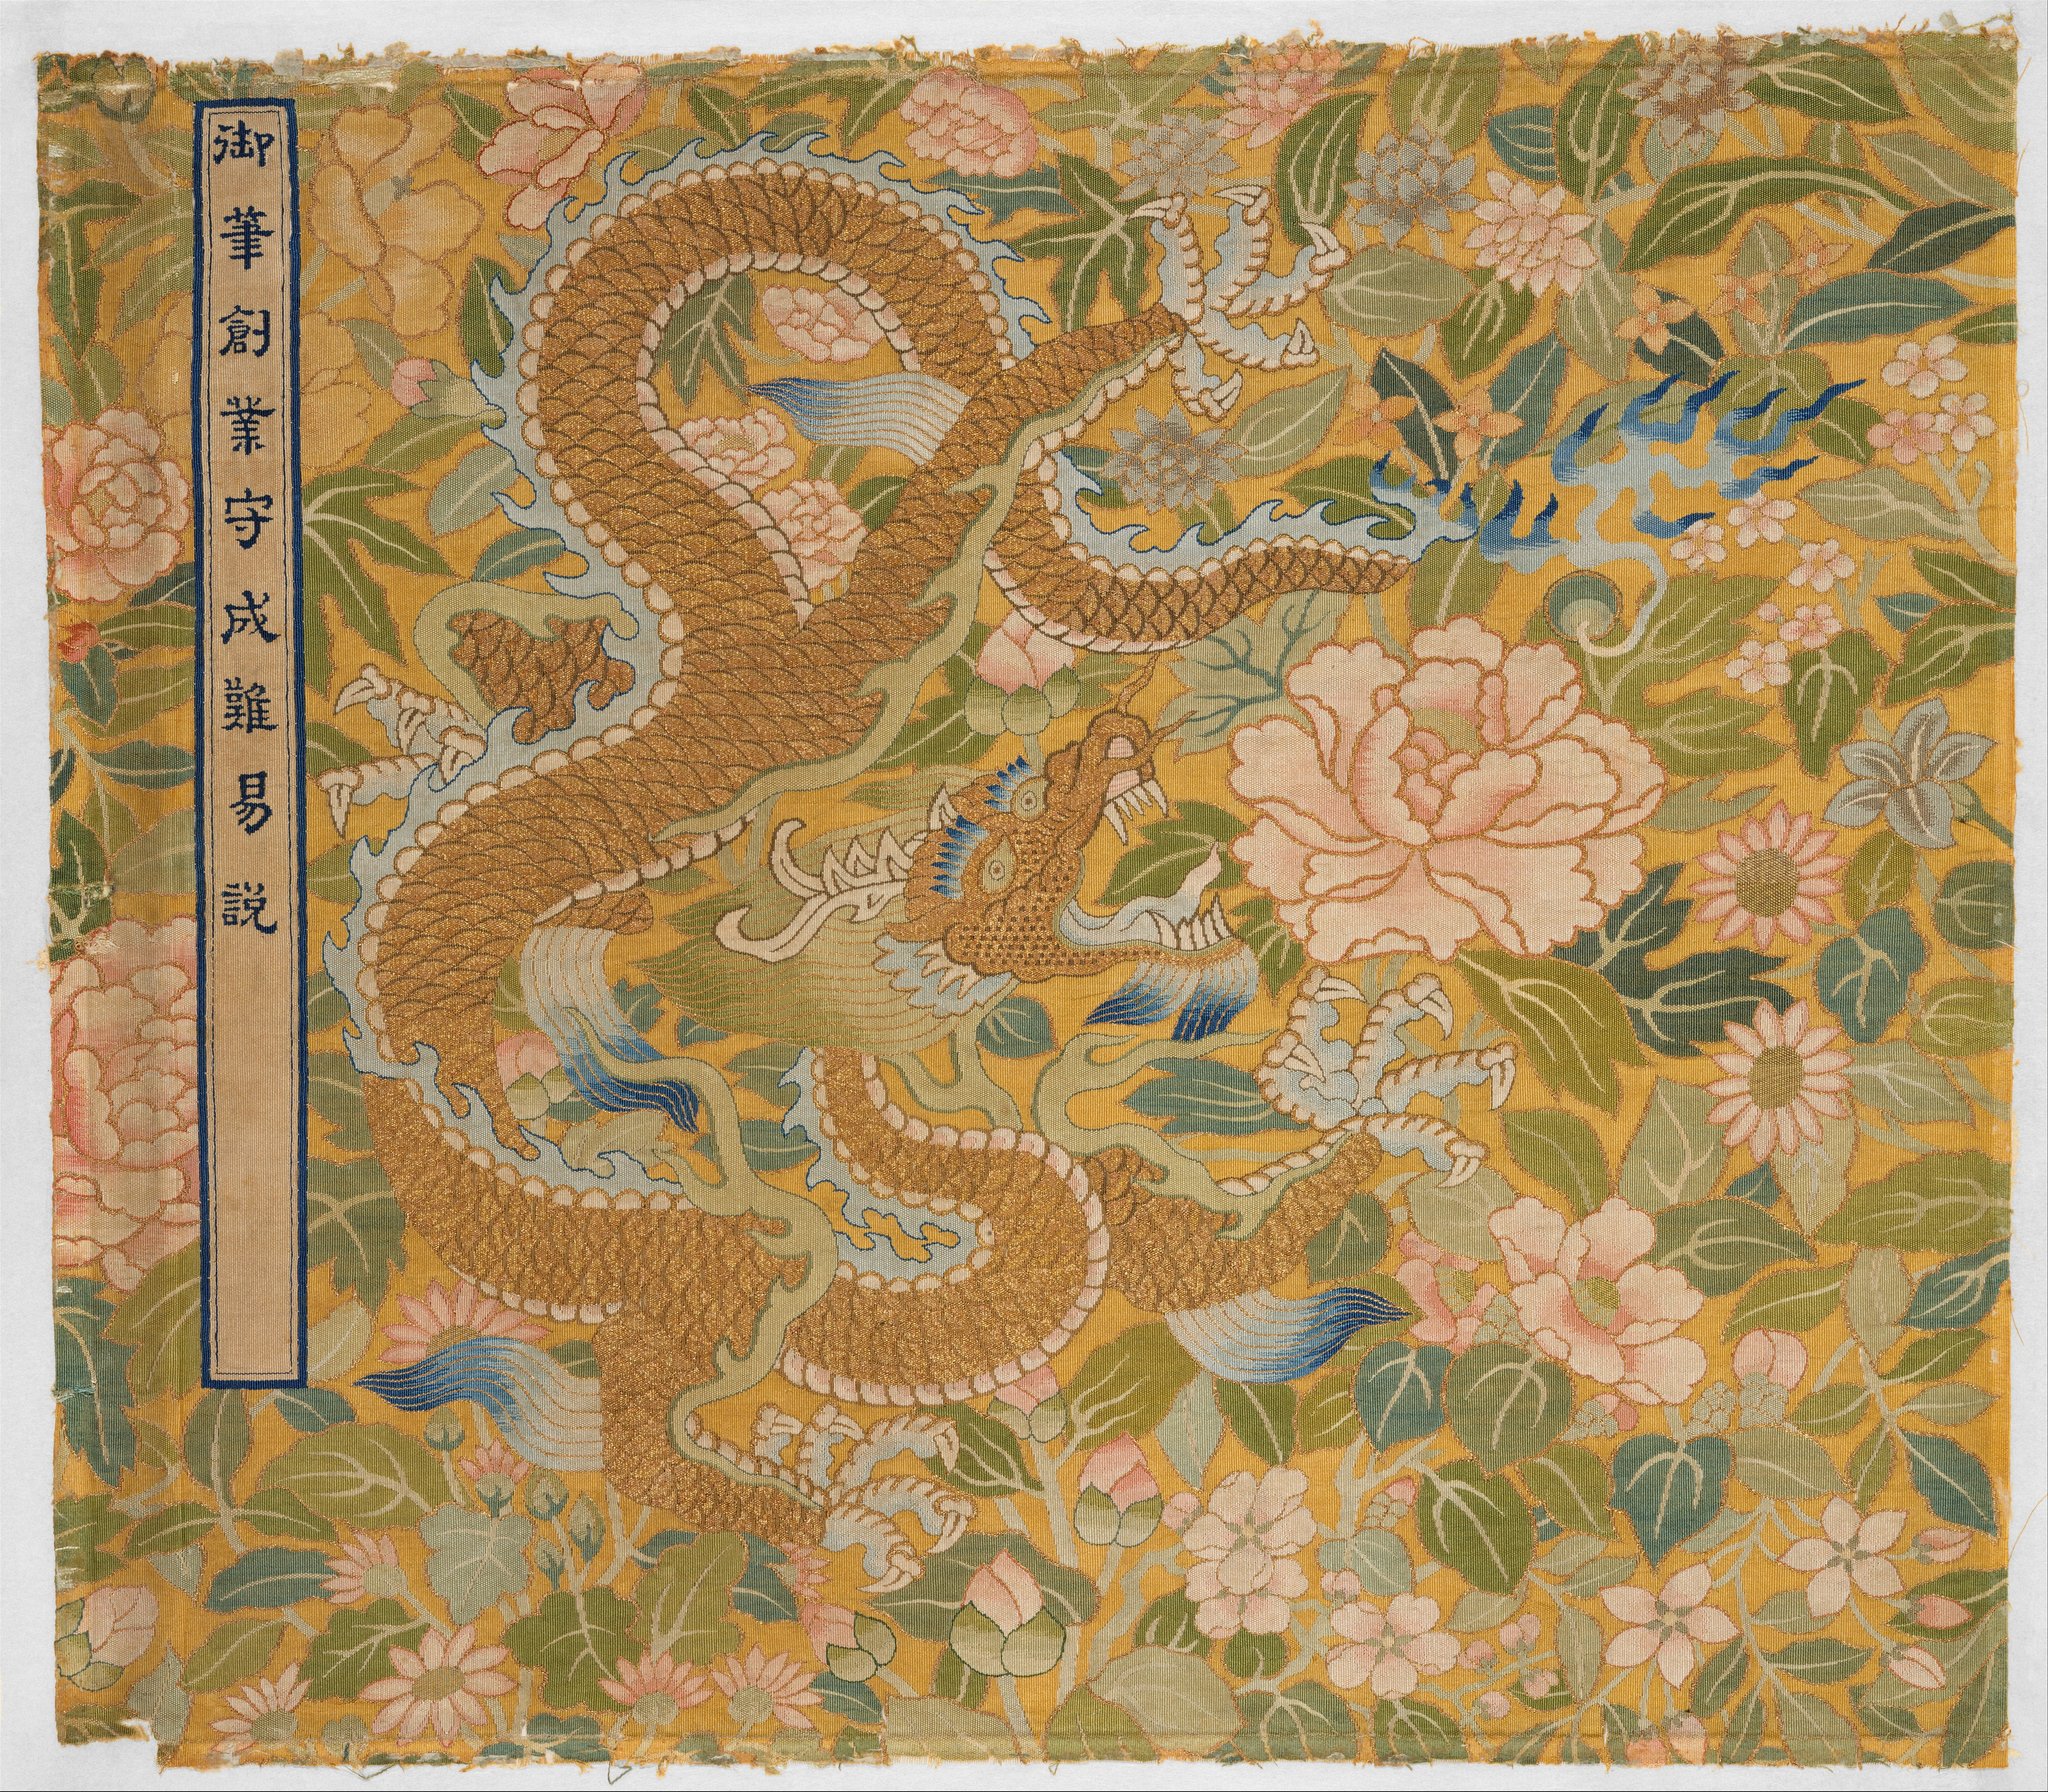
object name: scroll cover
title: Scroll Cover for Imperial Calligraphy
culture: chinese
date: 1736-1795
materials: metal thread, silk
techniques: tapestry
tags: dragons,flowers